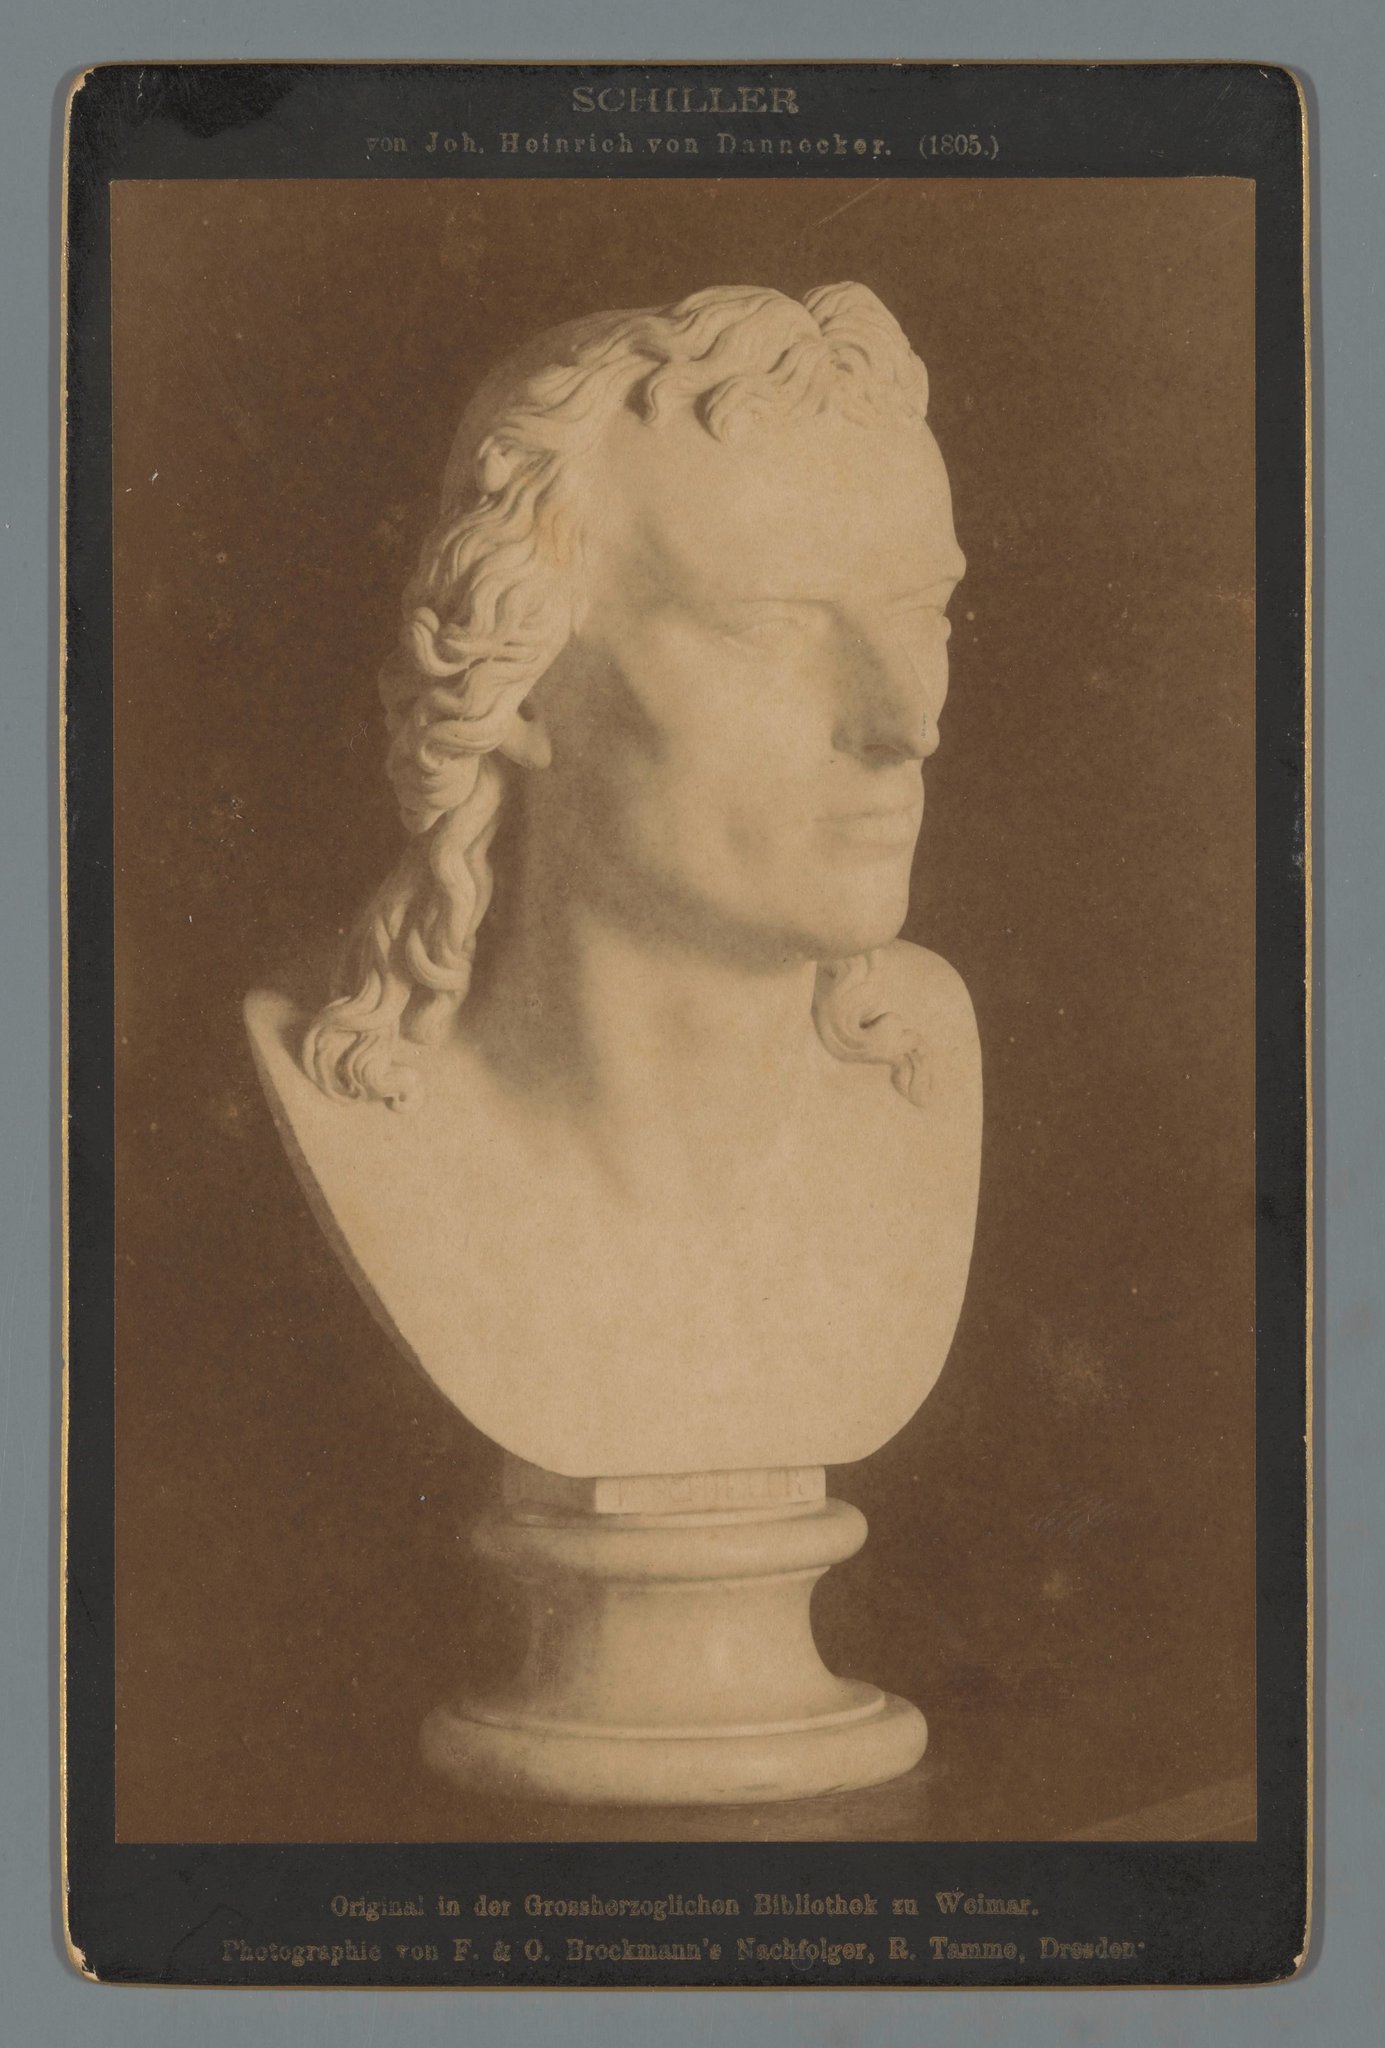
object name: cabinet photograph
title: Schiller von Joh. Heinrich von Dannecker (1805)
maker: rudolph tamme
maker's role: fotograaf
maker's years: 1835-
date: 1870-1890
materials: cardboard, photographic support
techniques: albumen print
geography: weimar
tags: friedrich von schiller, sculpture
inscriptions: : ‘Photographie von F. & O. Brockmann's Nachfolger, R. Tamme, Dresden’, : ‘Schiller’, : ‘Original in der Grossherzoglichen Bibliothek in Weimar’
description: Portretbuste door beeldhouwer Joh. Heinrich von Dannecker